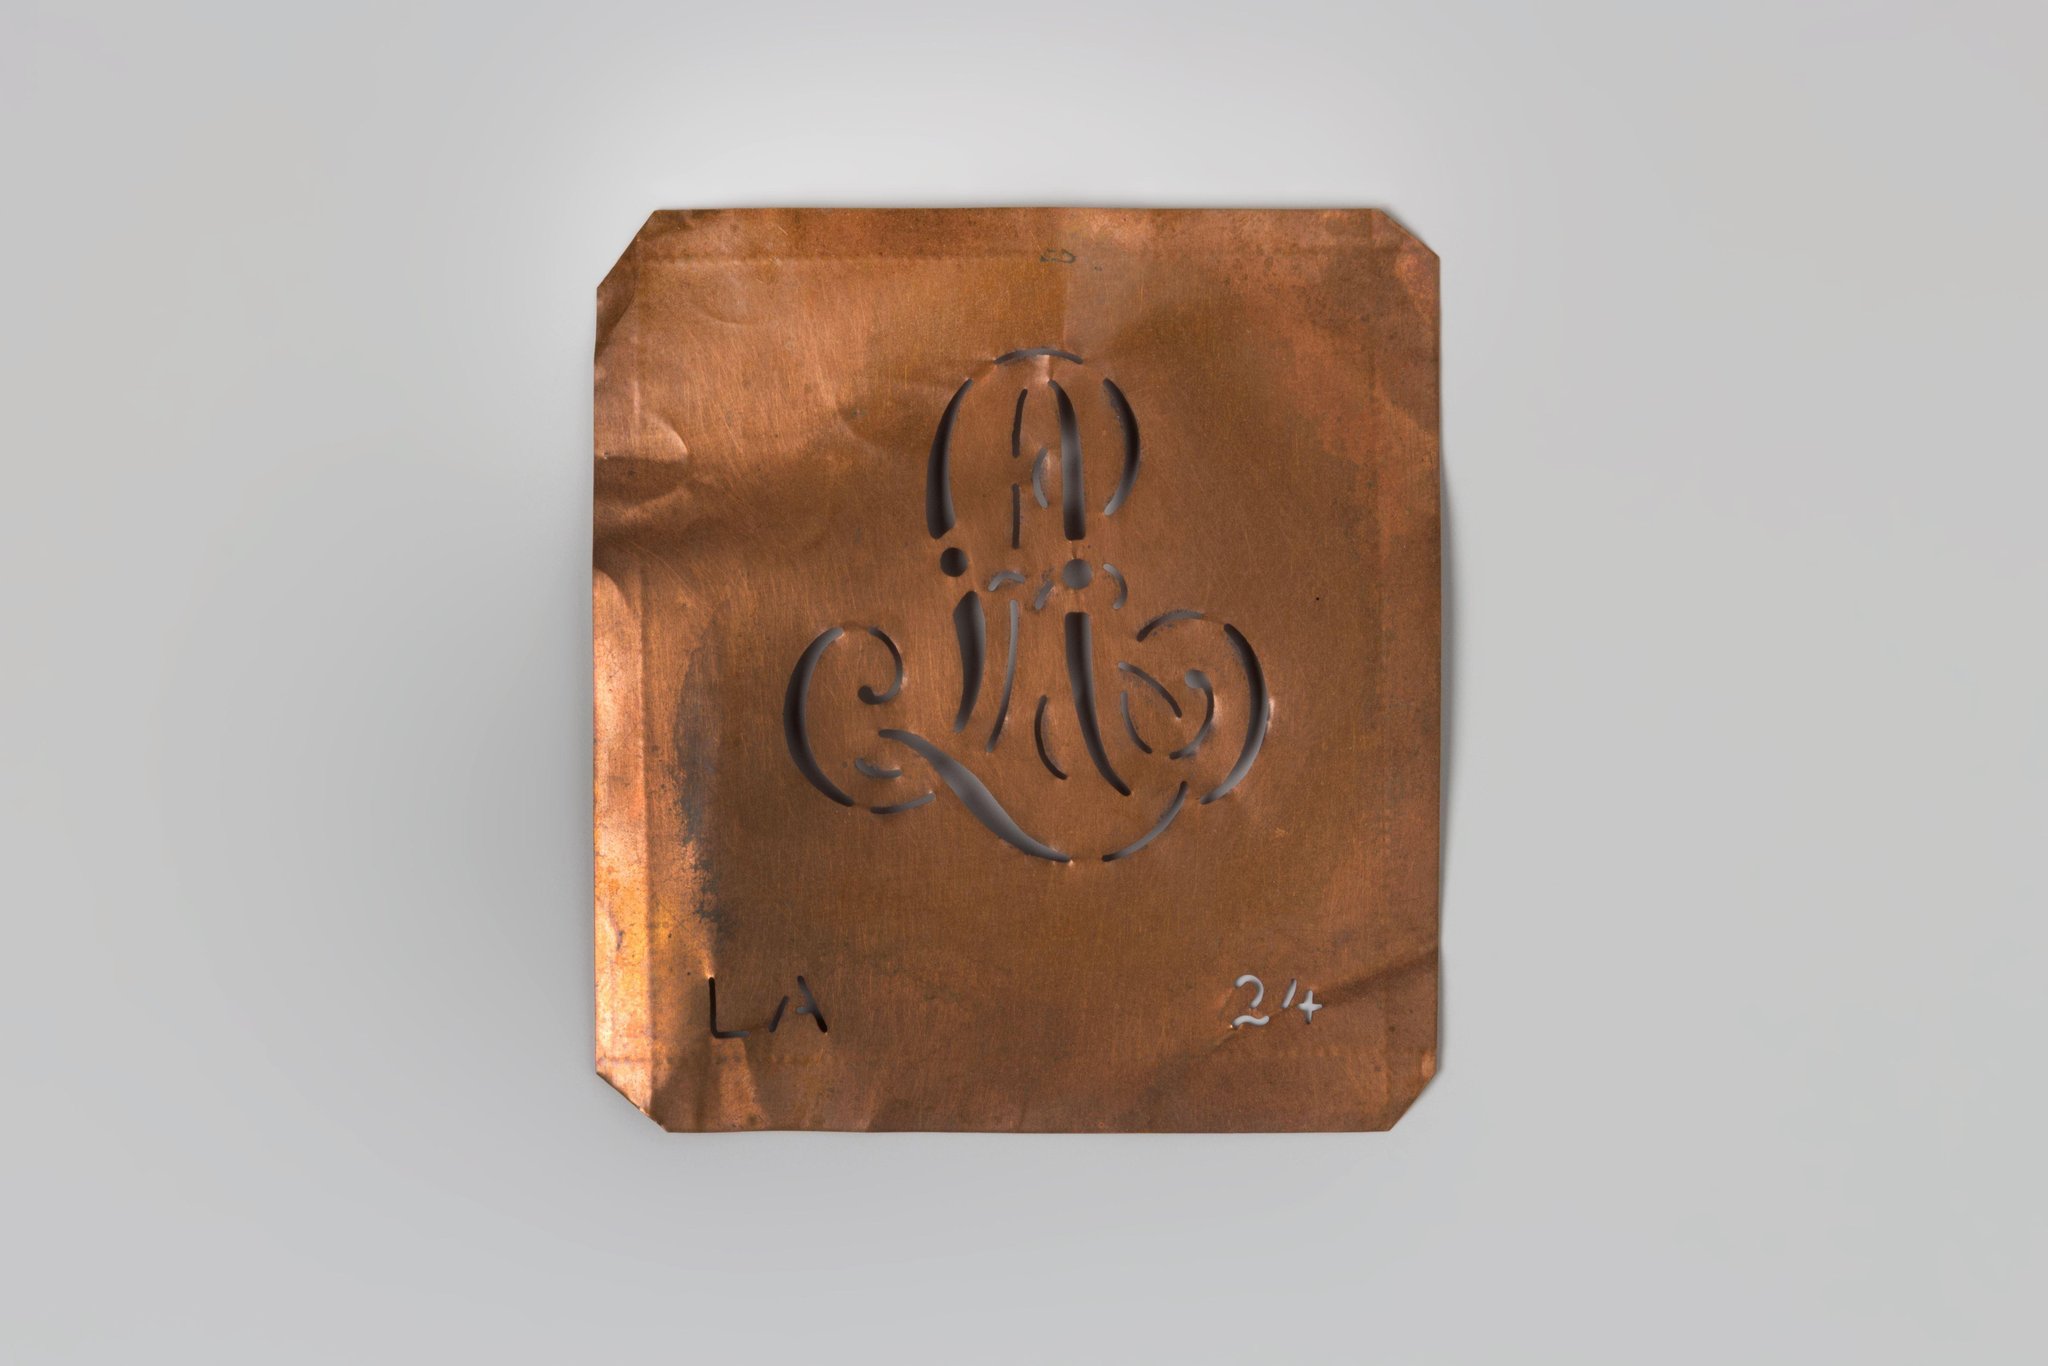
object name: template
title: Sjabloon van rood koper, rechthoekig, met uitgestanste initialen 'LA', zeer fijn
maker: Anonymous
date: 1900-1925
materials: copper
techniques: manufacturing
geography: netherlands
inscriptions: inscription: ‘'LA' en '24'’, initials: ‘'LA'’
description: Sjabloon van rood koper, voor initiaal L.A. Rechthoekig, met vouwrandjes en de calligrafische letters uitgelegd onderaan. Zeer fijn. Mogelijk voor borduurwerk.